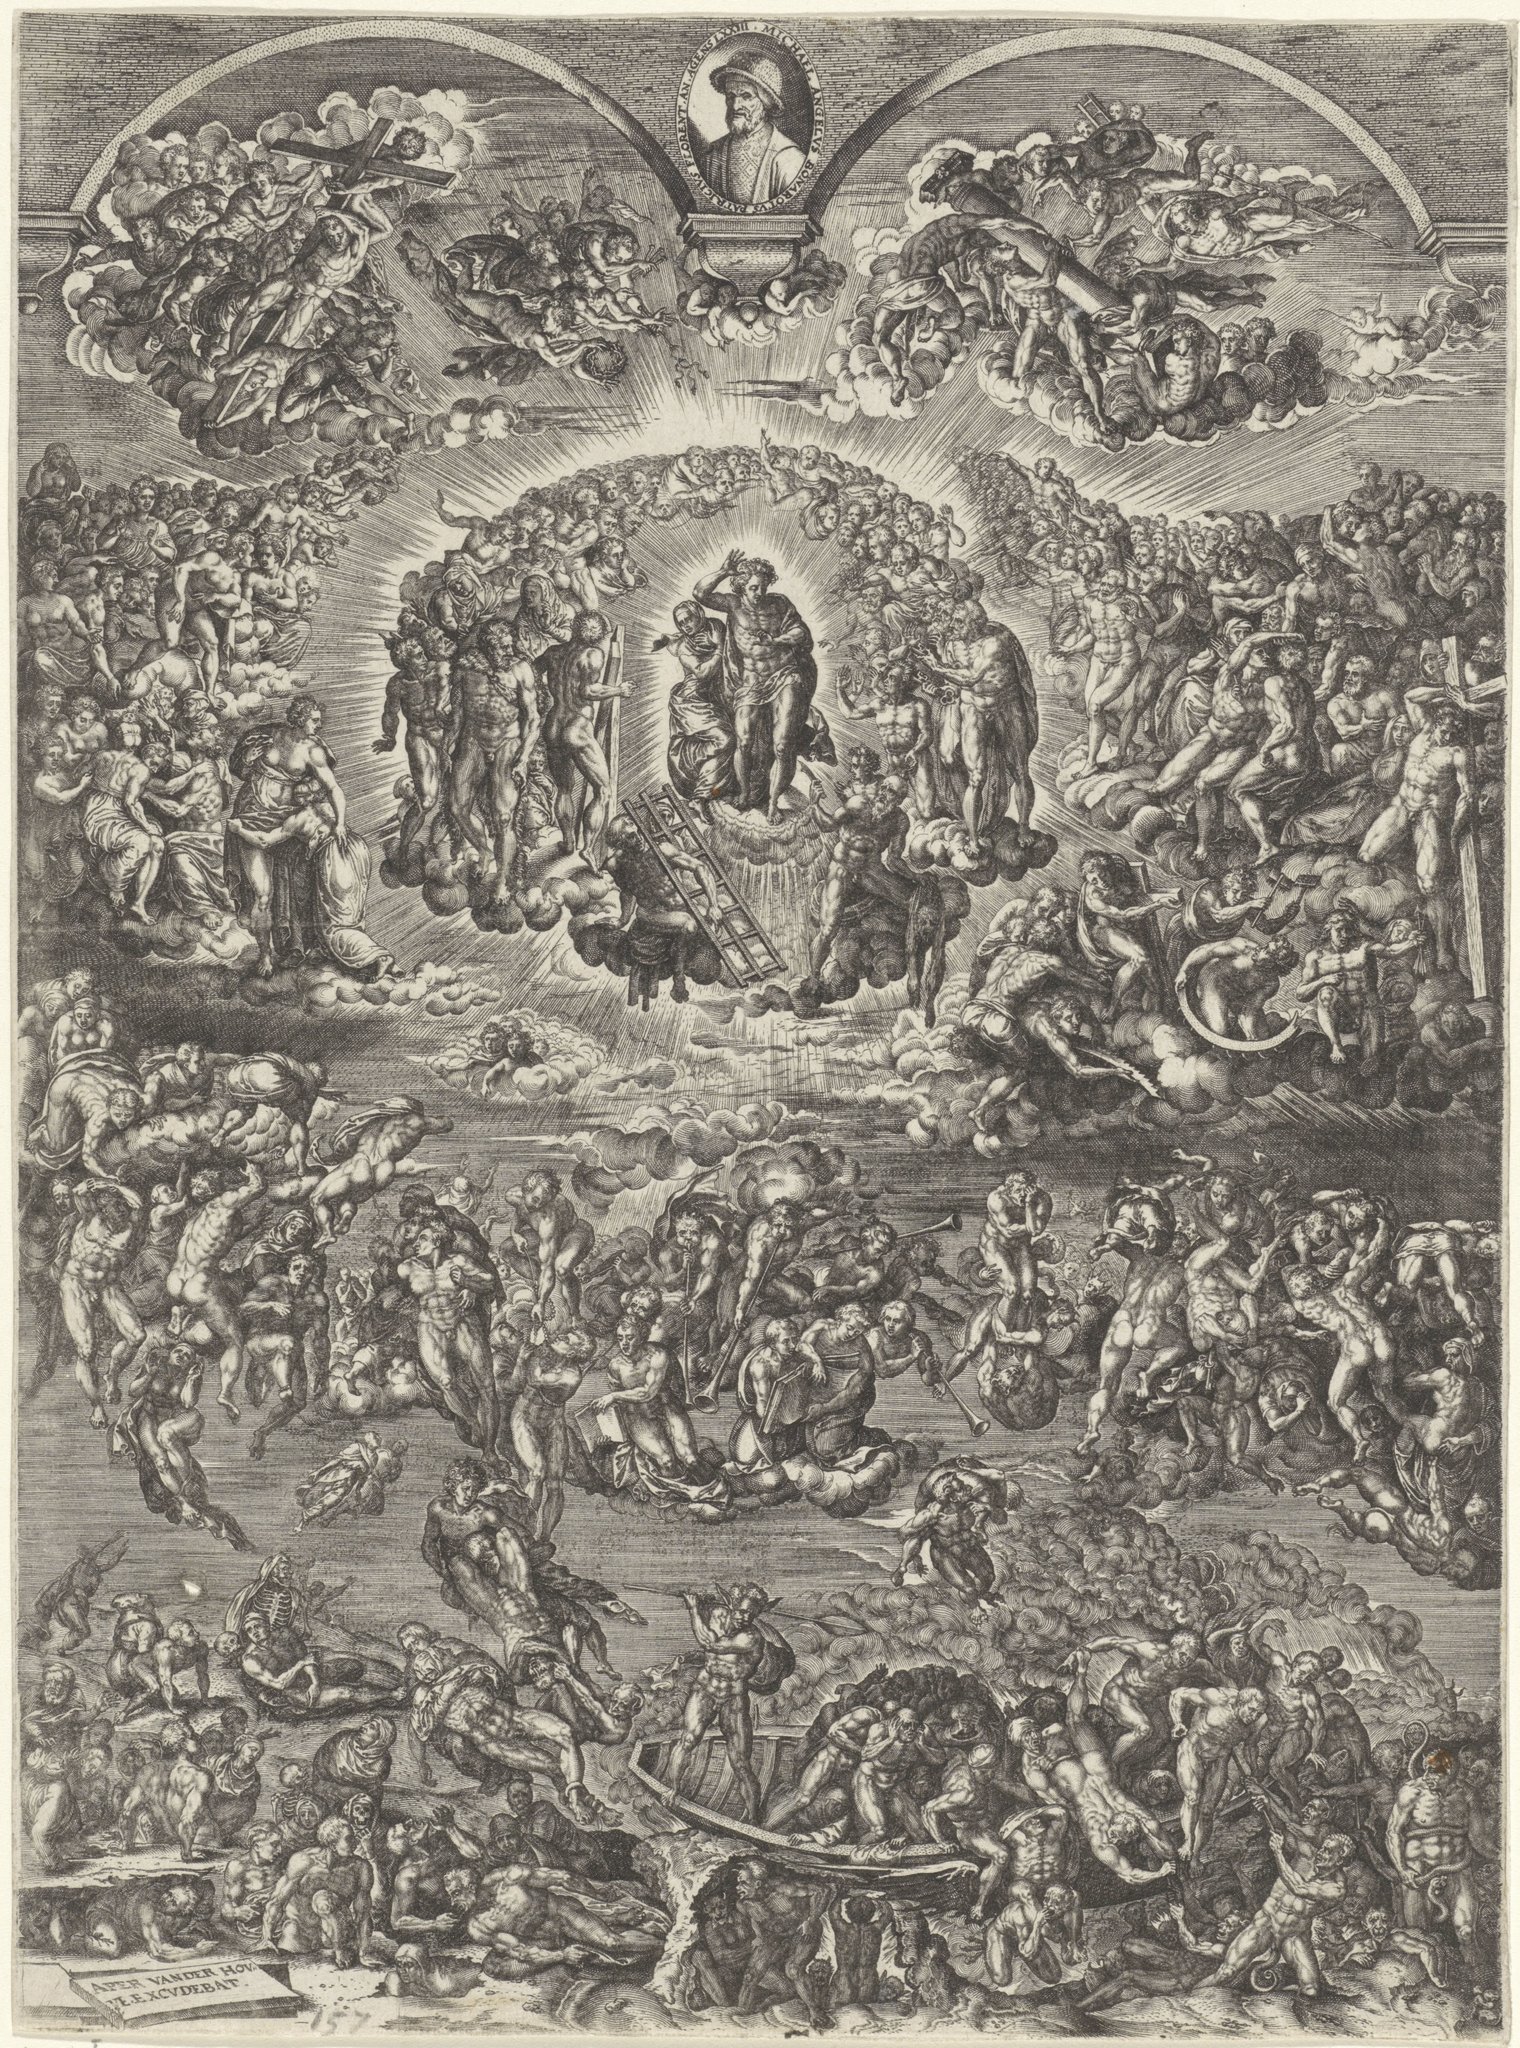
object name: print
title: Laatste Oordeel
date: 1575-1579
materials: paper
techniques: engraving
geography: delft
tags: rome, painter, sculptor, michelangelo, comprehensive representation of last judgement: christ (with sword and lily), often surrounded by elders and sometimes accompanied by mary and john the baptist, appears in the sky with trumpeting angels (and sometimes angels holding the instruments of the passion); after the resurrection of the dead the blessed are led to heaven by angels, and the damned are dragged into hell by devils, charon, the ferryman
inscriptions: collector's mark: Lugt 2228, collector's mark: Lugt 240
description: Christus treedt op als rechter. Hij staat op een wolk naast Maria. Met zijn geheven arm maakt hij een dreigend gebaar. Hij wordt omringd door groepen met cherubijnen, heiligen en apostelen. Geheel onderaan de verdoemden die door duivels meegenomen worden naar de hel en daar worden gefolterd. Charon zet de doden over met zijn boot. Bovenaan een portret van de schilder Michelangelo, op 73-jarige leeftijd. De prent is gemaakt naar diens fresco in de Sixtijnse kapel te Rome.